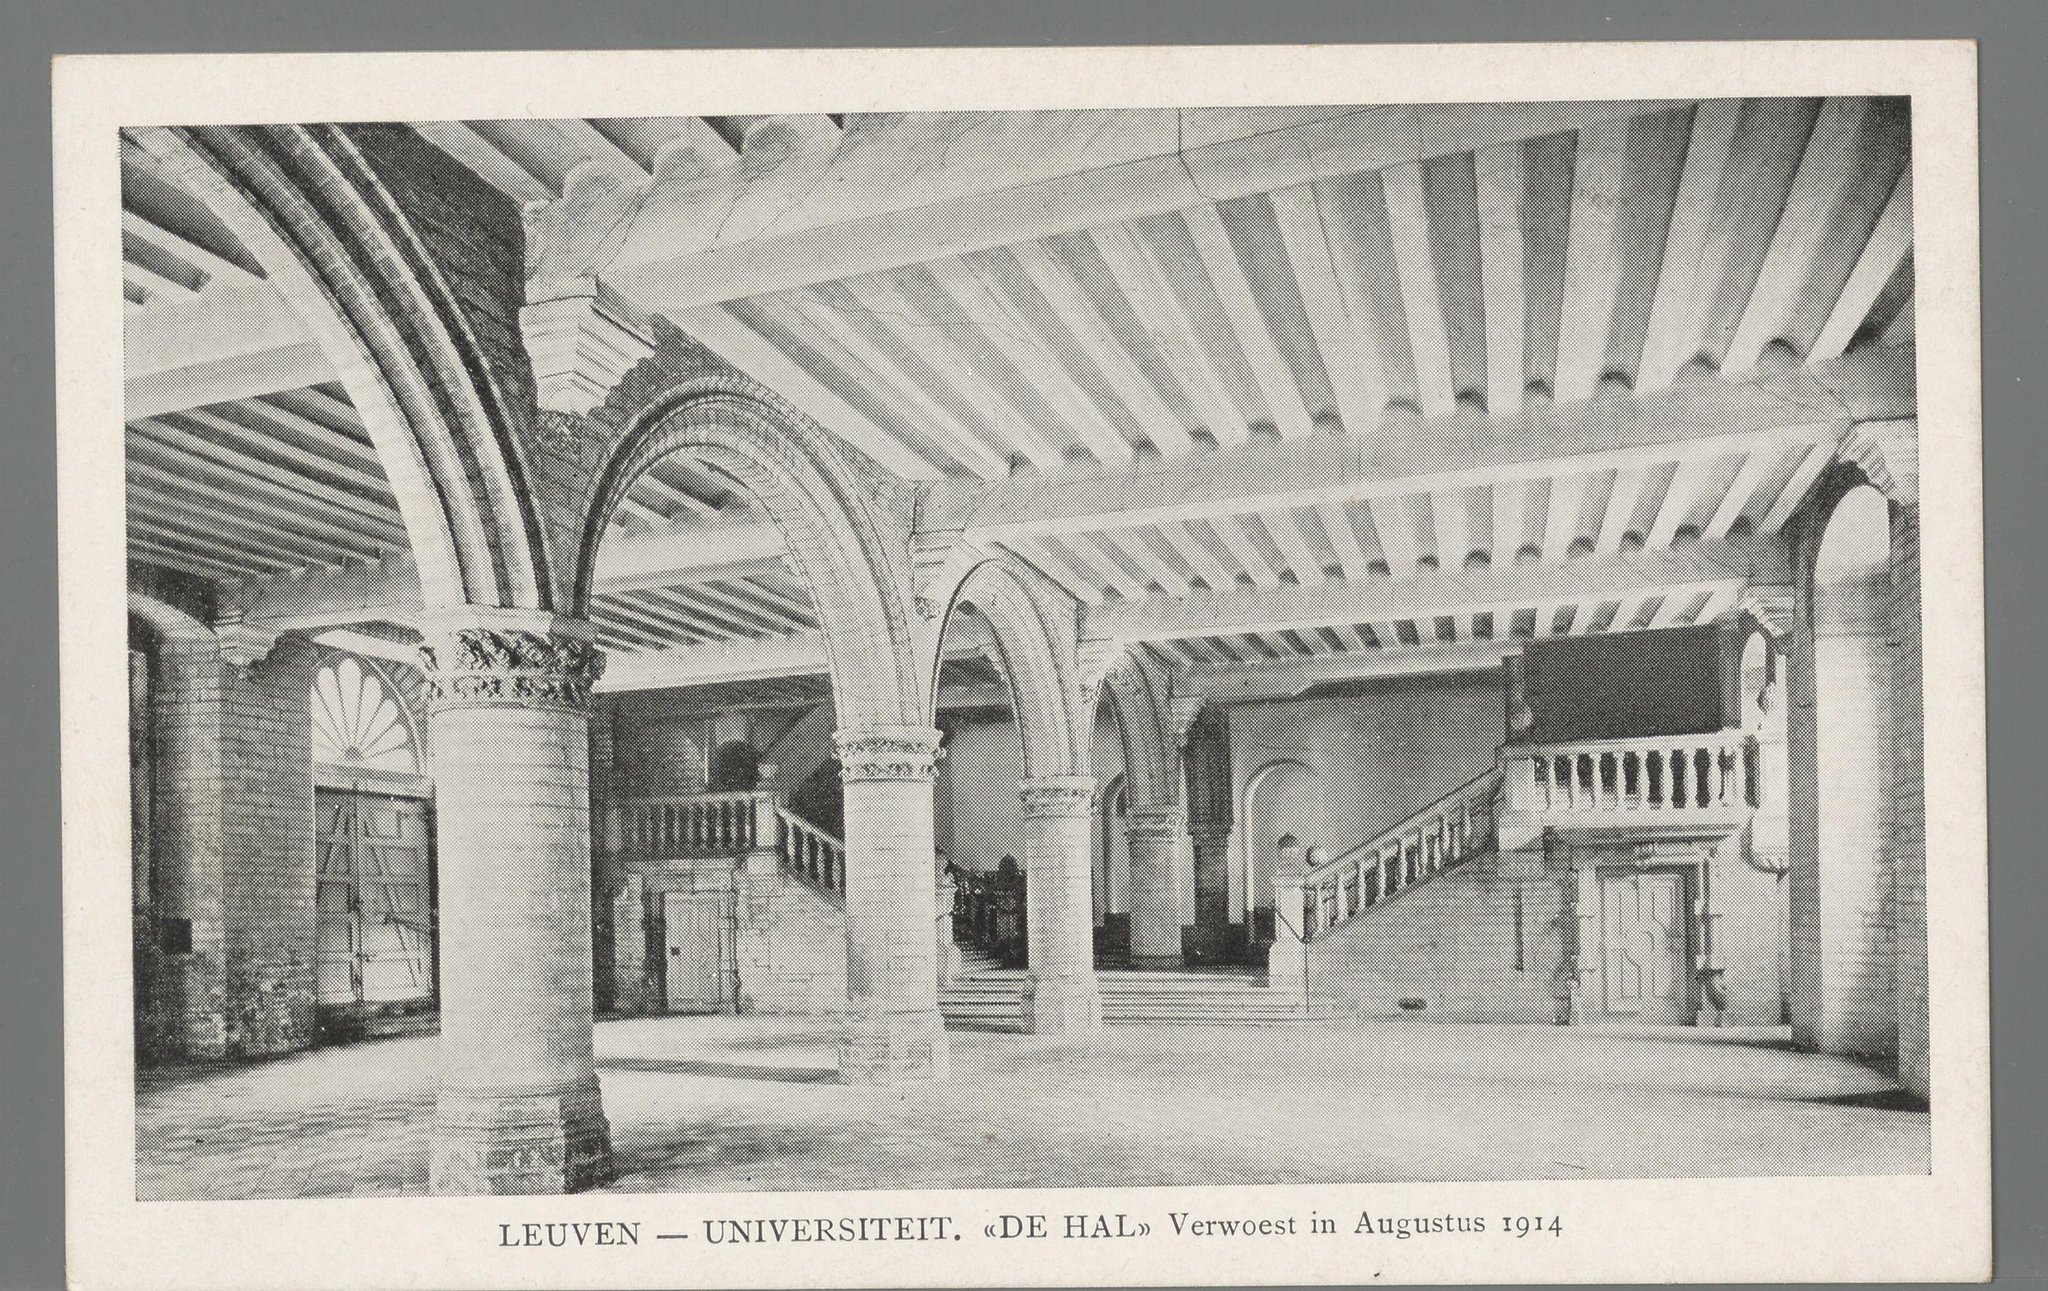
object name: photomechanical print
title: Leuven. Universiteit. "De Hal". Verwoest in Augustus 1914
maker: Anonymous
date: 1914-1930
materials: cardboard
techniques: autotype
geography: leuven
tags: university (+ building ~ education, tuition), interior ~ representation of a building, louvain